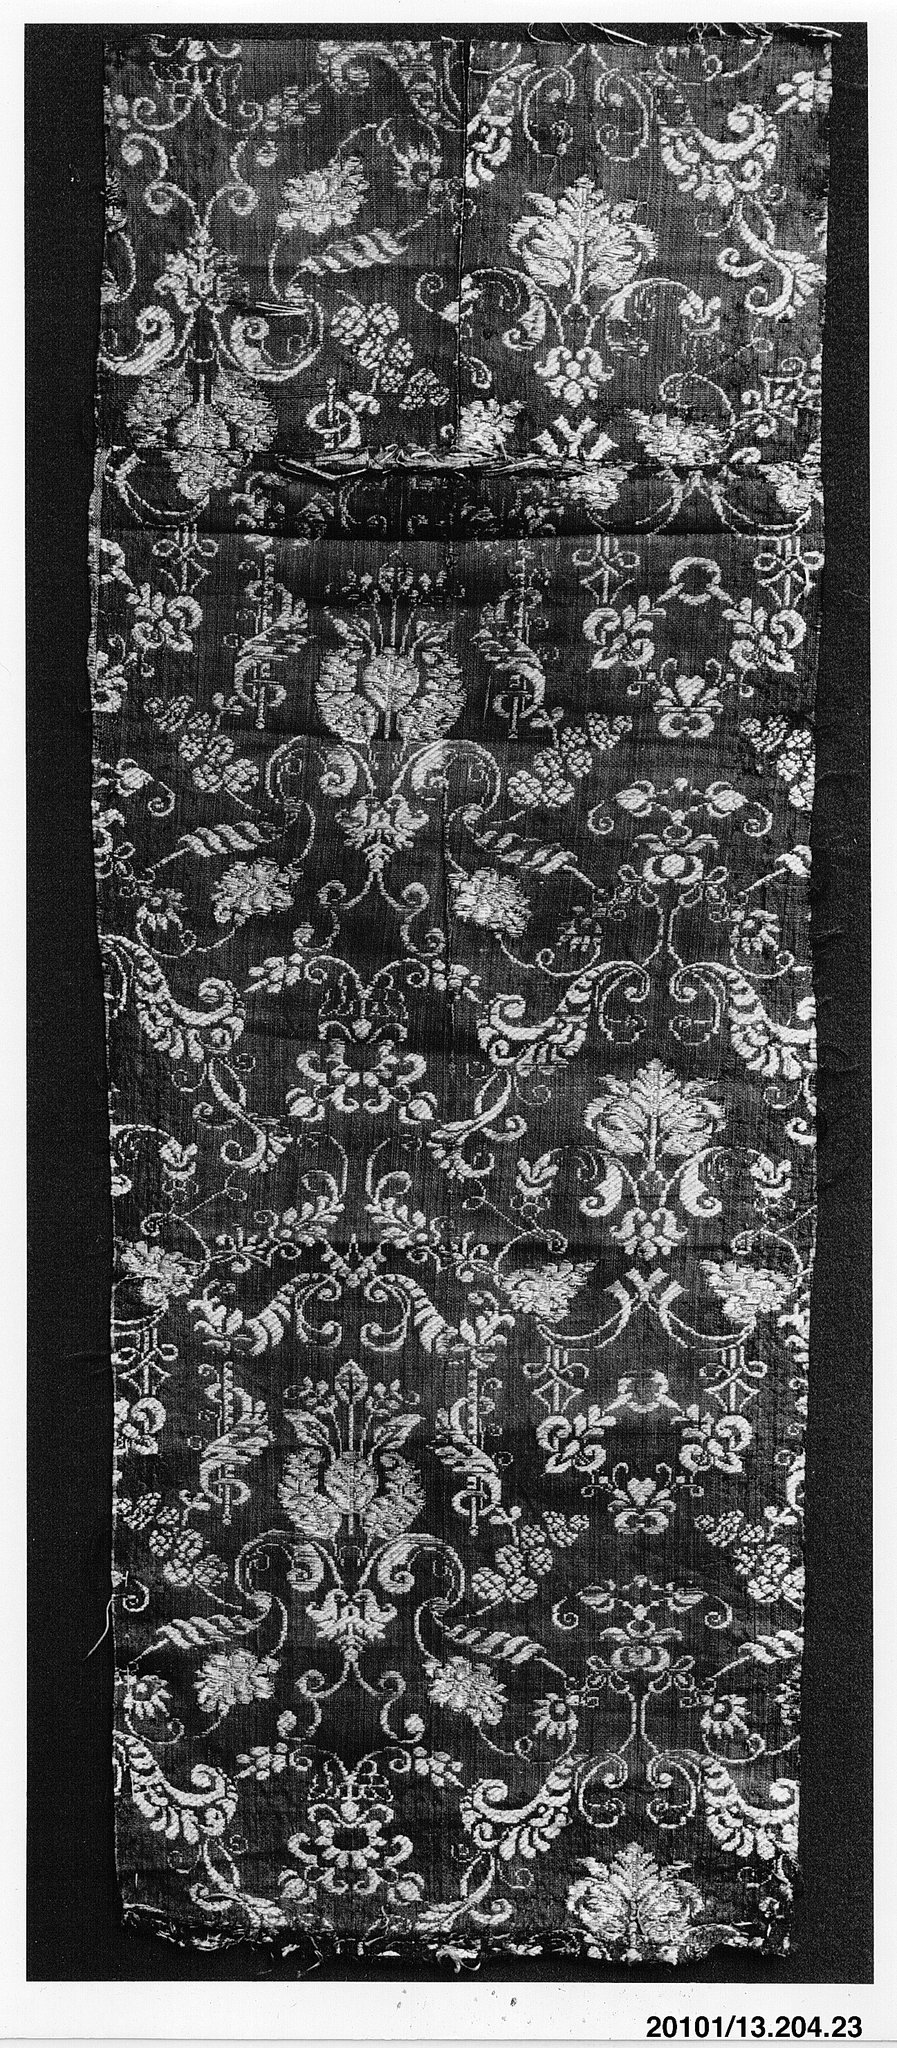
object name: piece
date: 1650-1660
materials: metal thread, silk